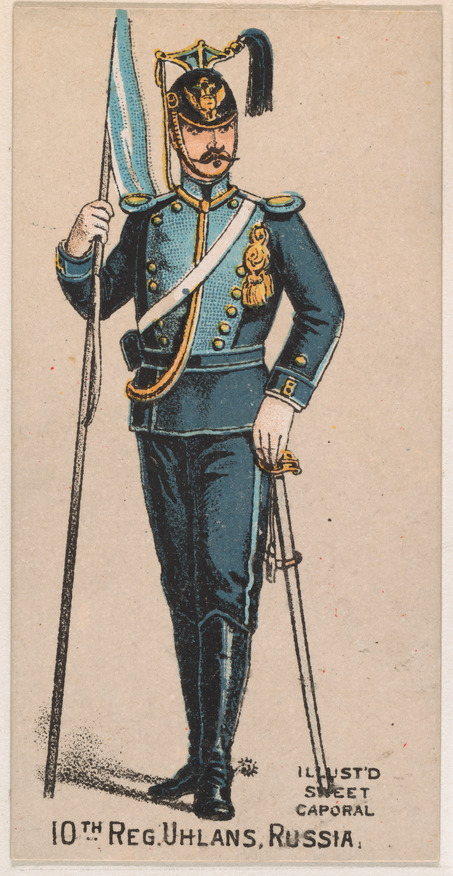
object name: print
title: 10th Regiment, Uhlans, Russia, from the Military Series (N224) issued by Kinney Tobacco Company to promote Sweet Caporal Cigarettes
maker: kinney brothers tobacco company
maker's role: publisher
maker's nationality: american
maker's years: 1869-2011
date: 1888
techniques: color lithograph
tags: soldiers,swords,men